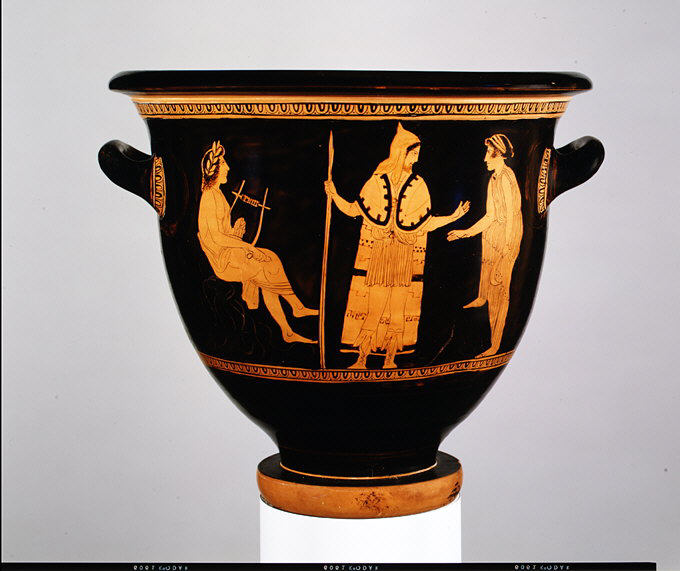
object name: bell krater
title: Terracotta bell-krater (bowl for mixing wine and water)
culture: greek, attic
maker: painter of london e 497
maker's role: artist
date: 440 BCE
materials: terracotta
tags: men,women,orpheus,musicians,lyres